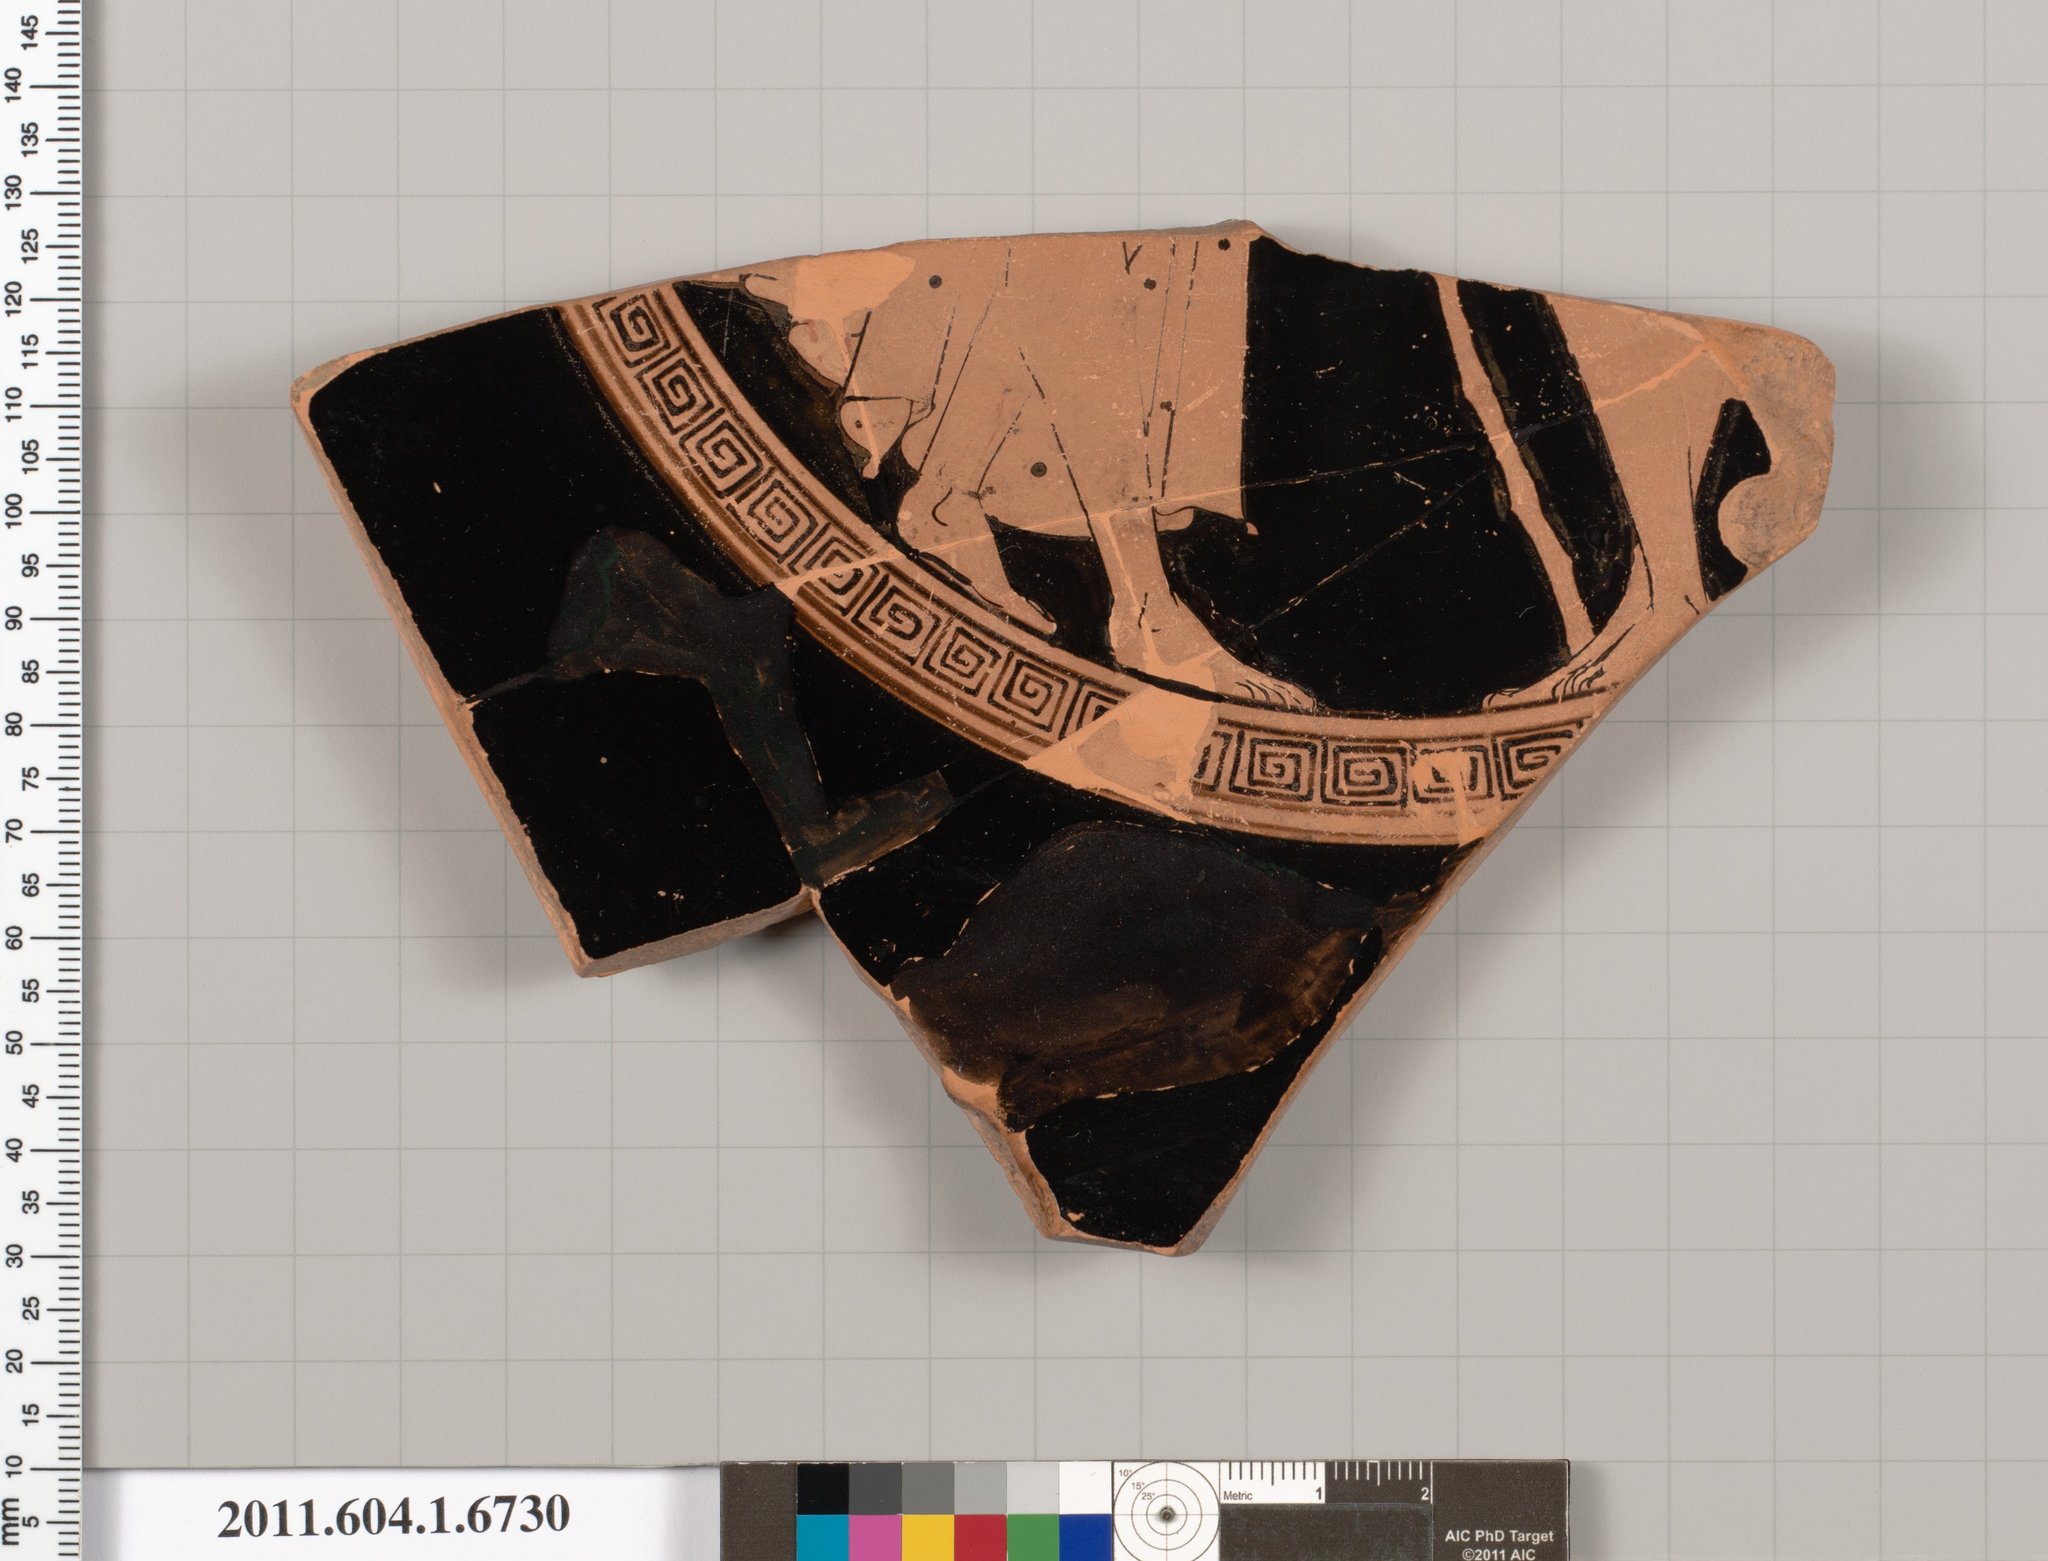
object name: kylix fragment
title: Terracotta fragment of a kylix (drinking cup)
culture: greek, attic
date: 490-470 BCE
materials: terracotta